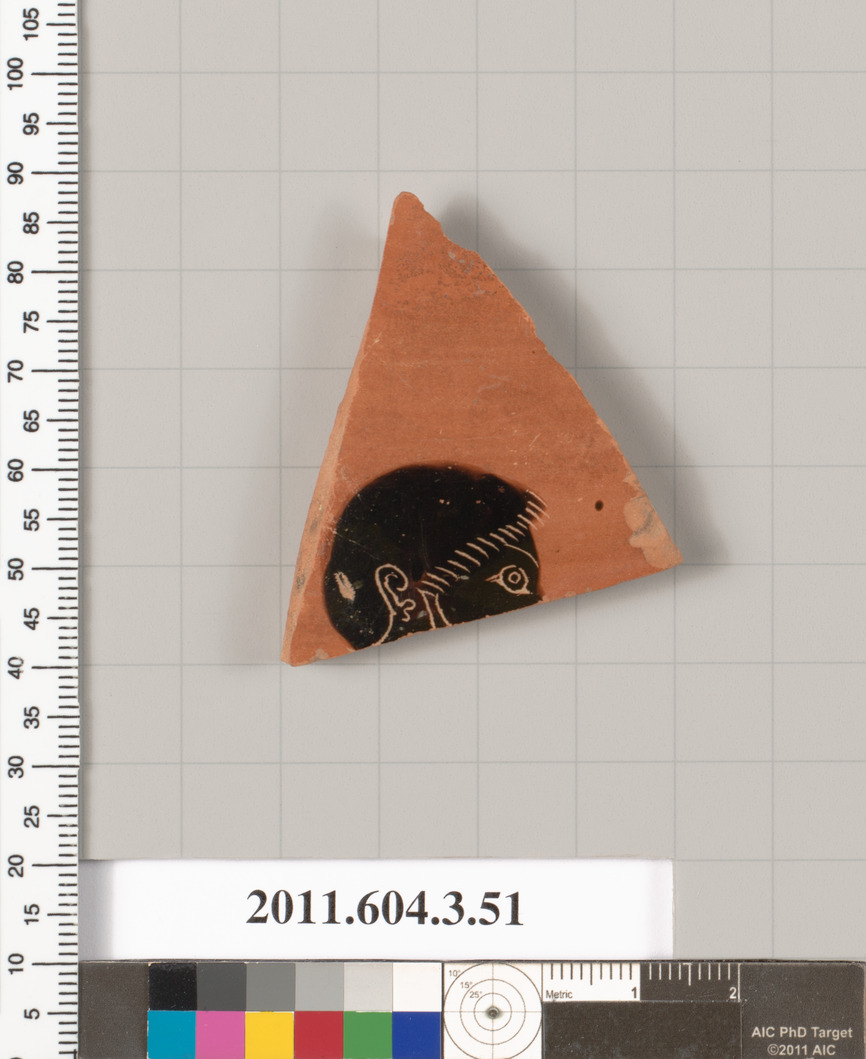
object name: amphora fragment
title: Terracotta fragment of an amphora (jar)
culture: greek, attic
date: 510-500 BCE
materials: terracotta